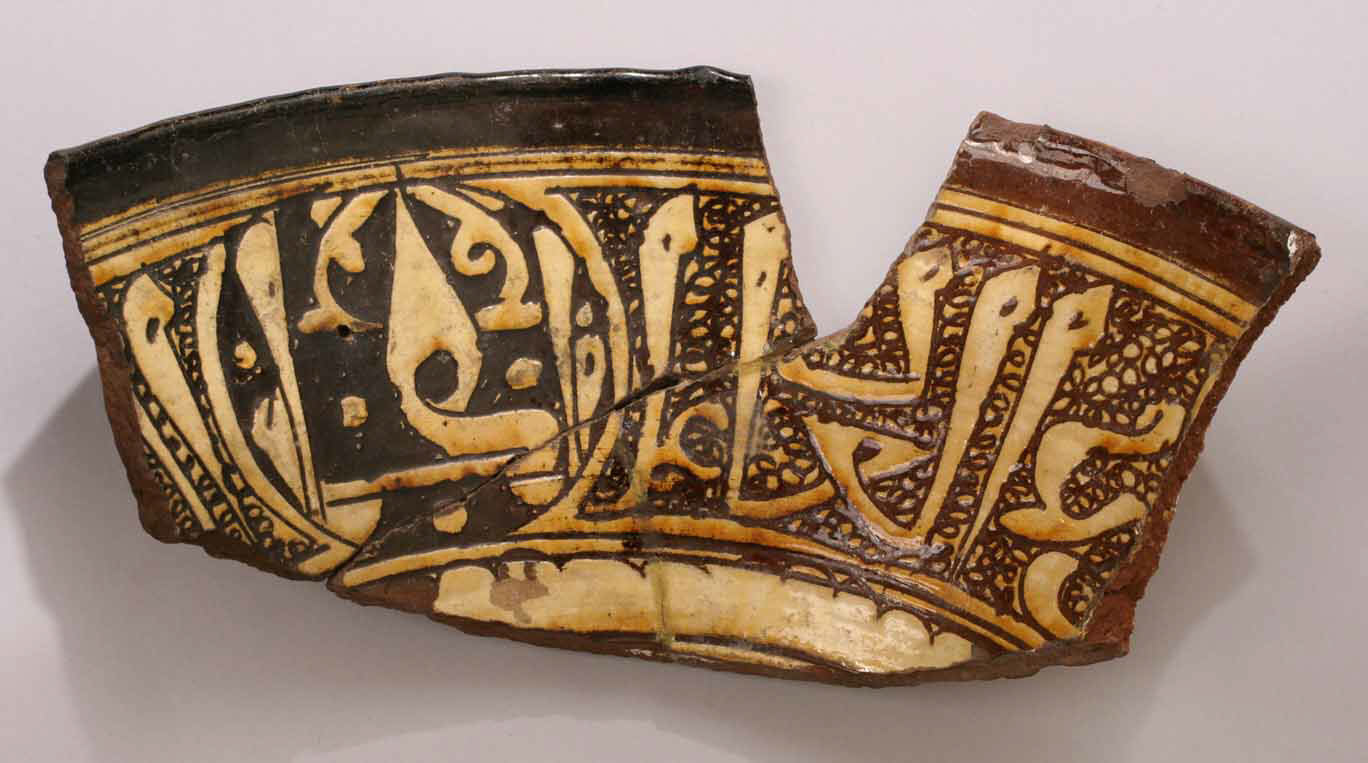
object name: fragment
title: Ceramic Fragment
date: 1301-1500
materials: earthenware, glaze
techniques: coloring, incising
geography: egypt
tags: arabic